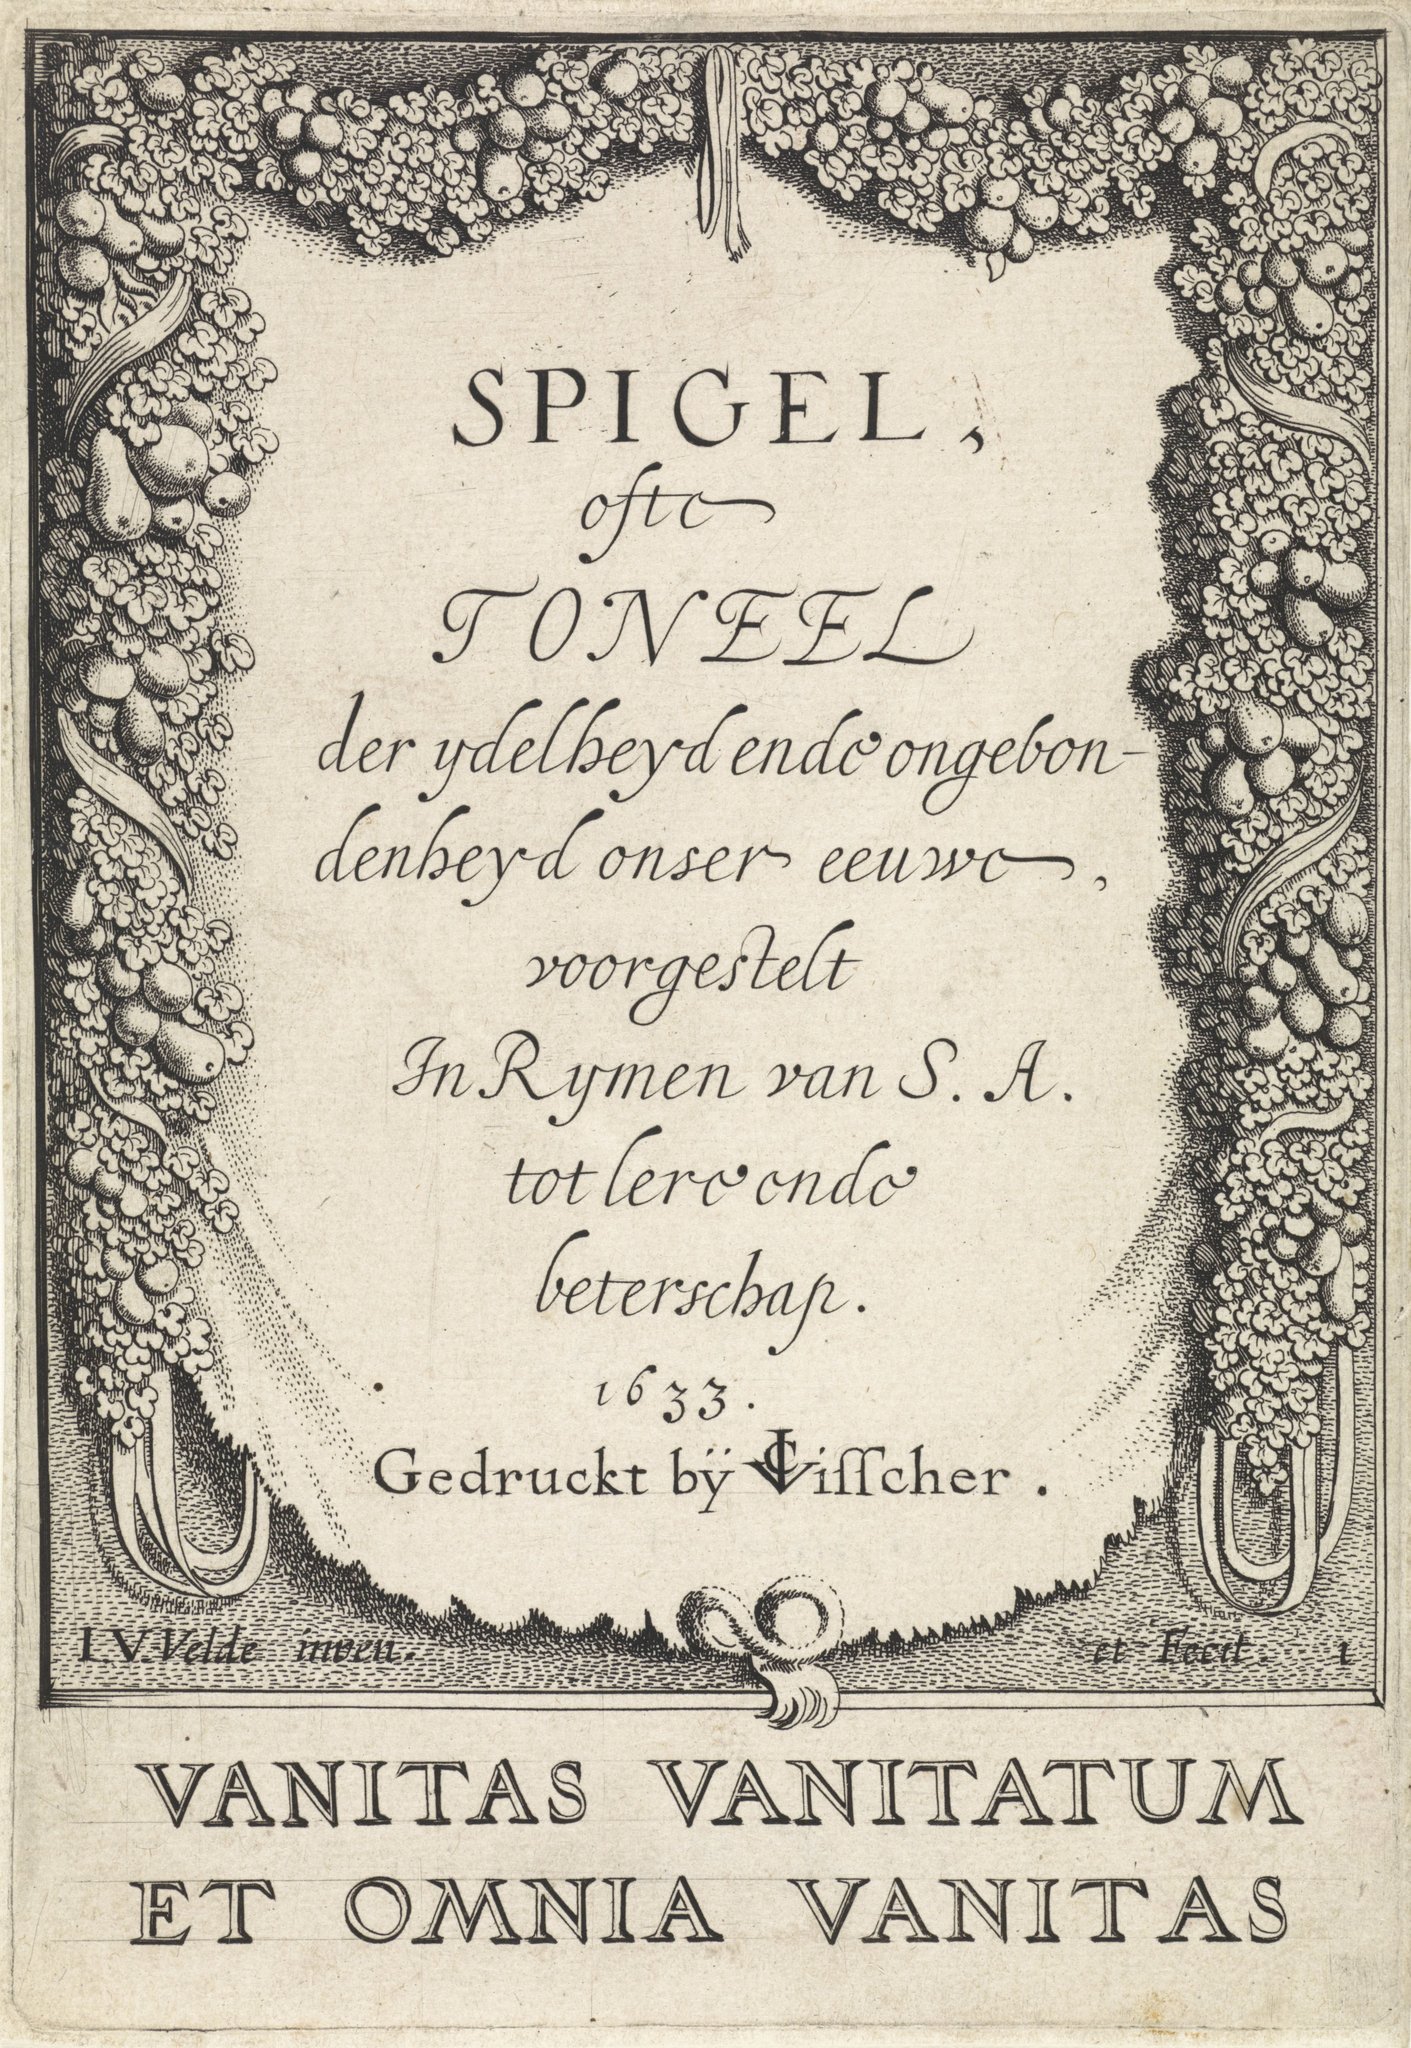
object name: titelprent, frontispice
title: Vanitas vanitatum et omania vanitas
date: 1633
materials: paper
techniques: etching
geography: amsterdam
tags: ornament ~ festoon, garland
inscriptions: collector's mark: Lugt 240